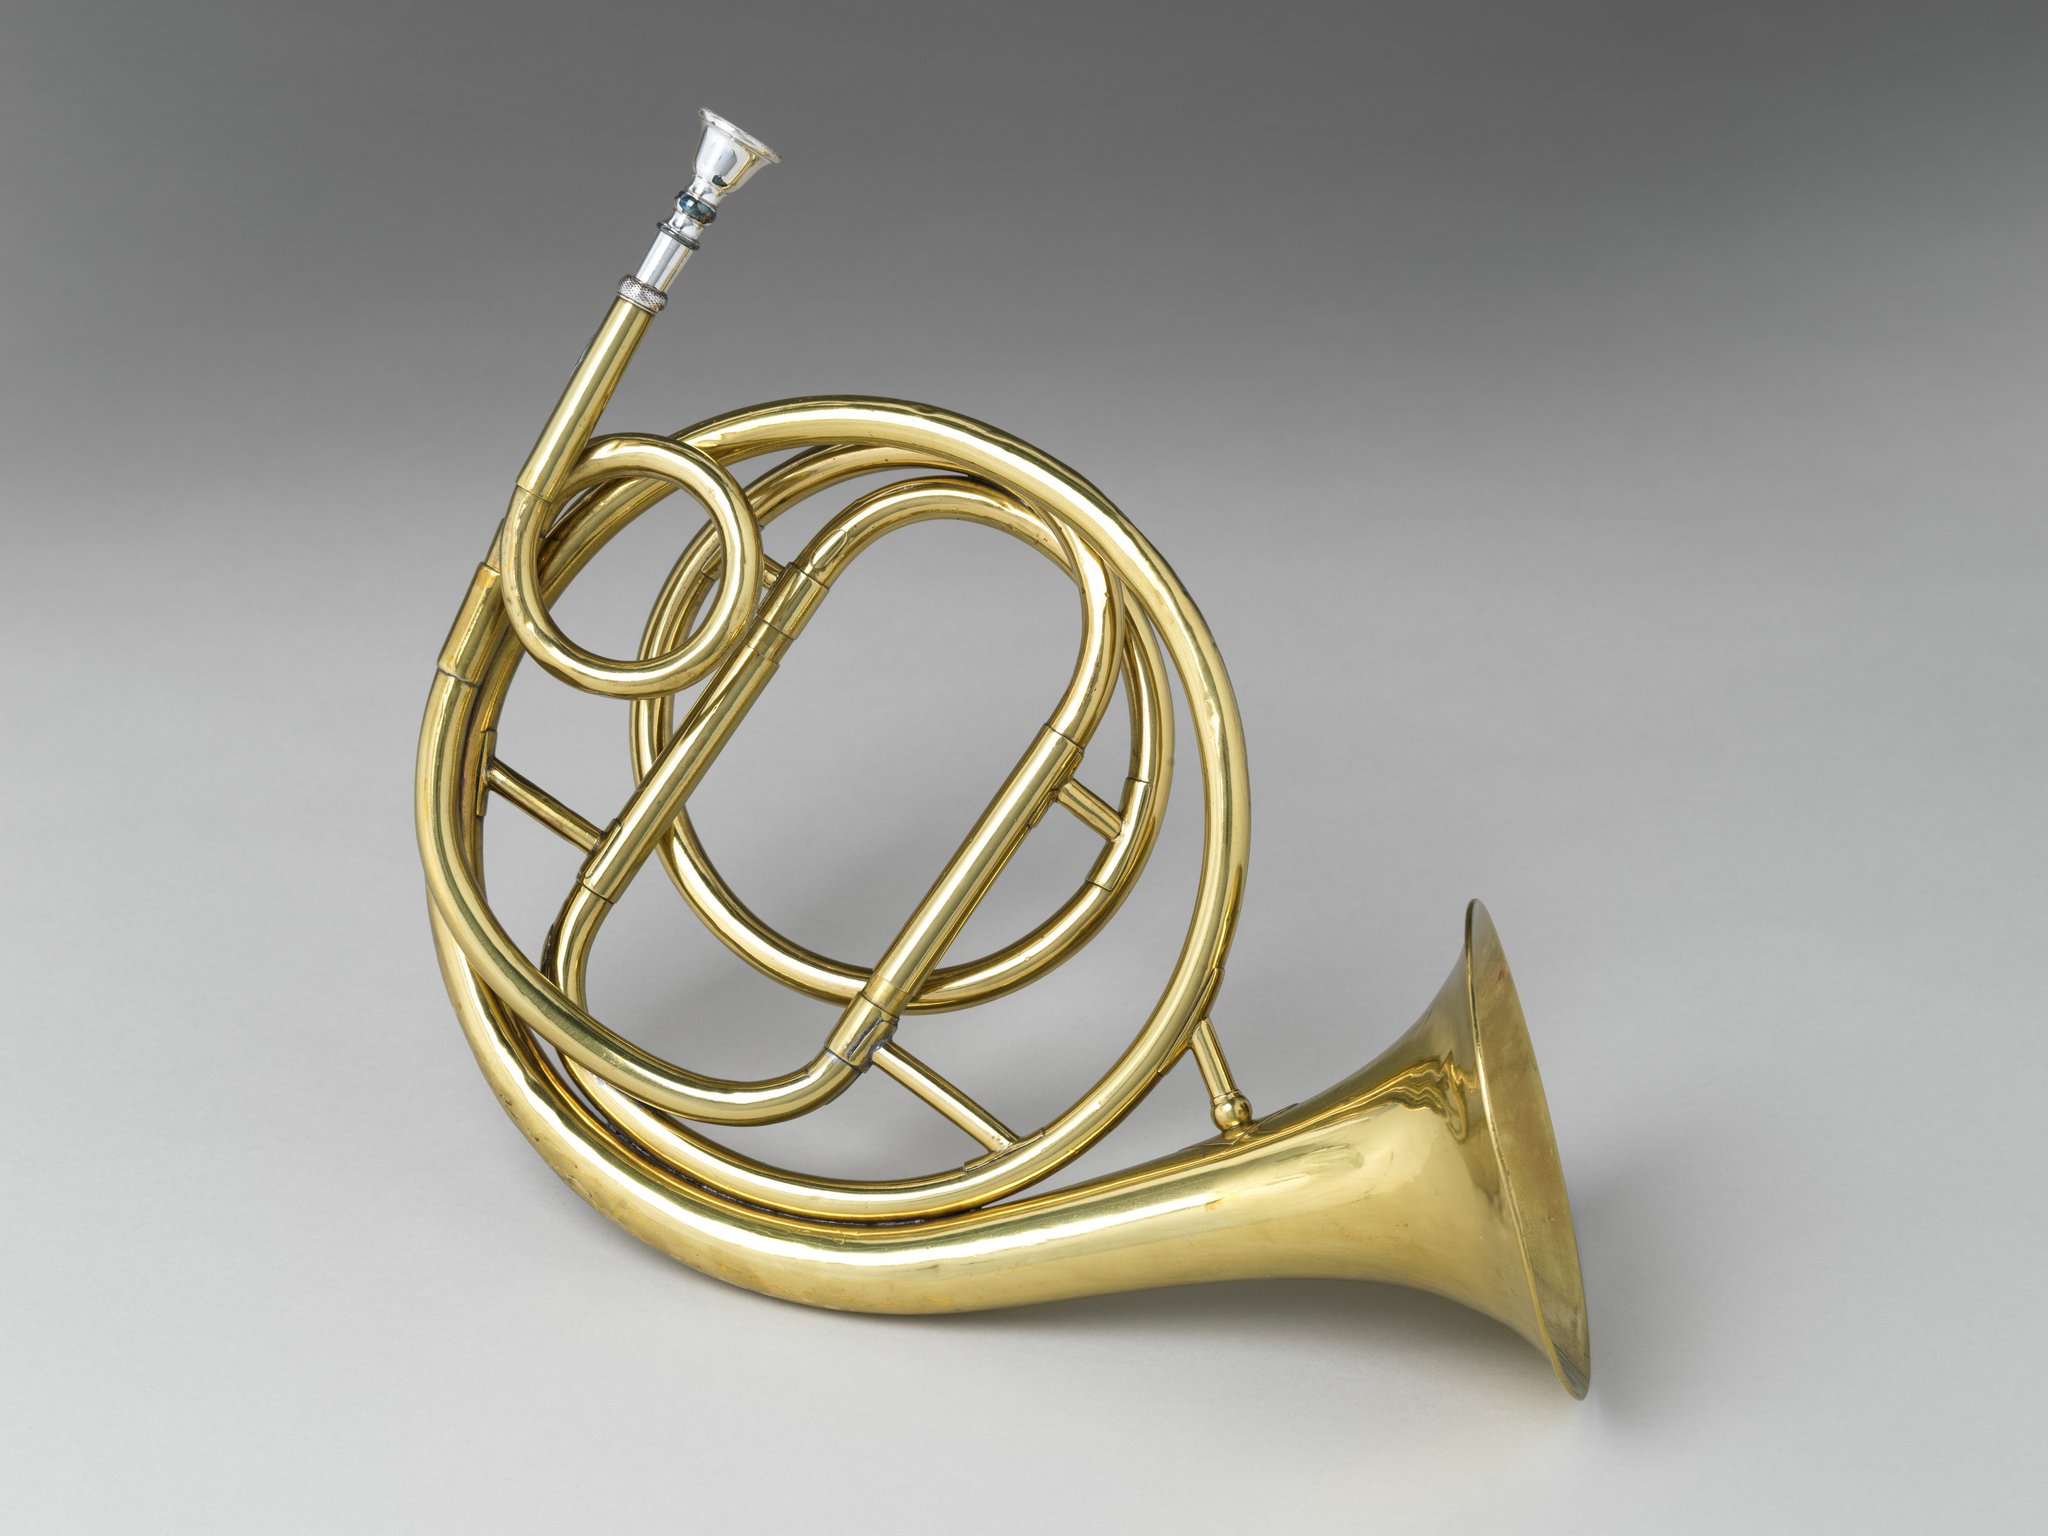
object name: circular trumpet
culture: french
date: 1830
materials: brass